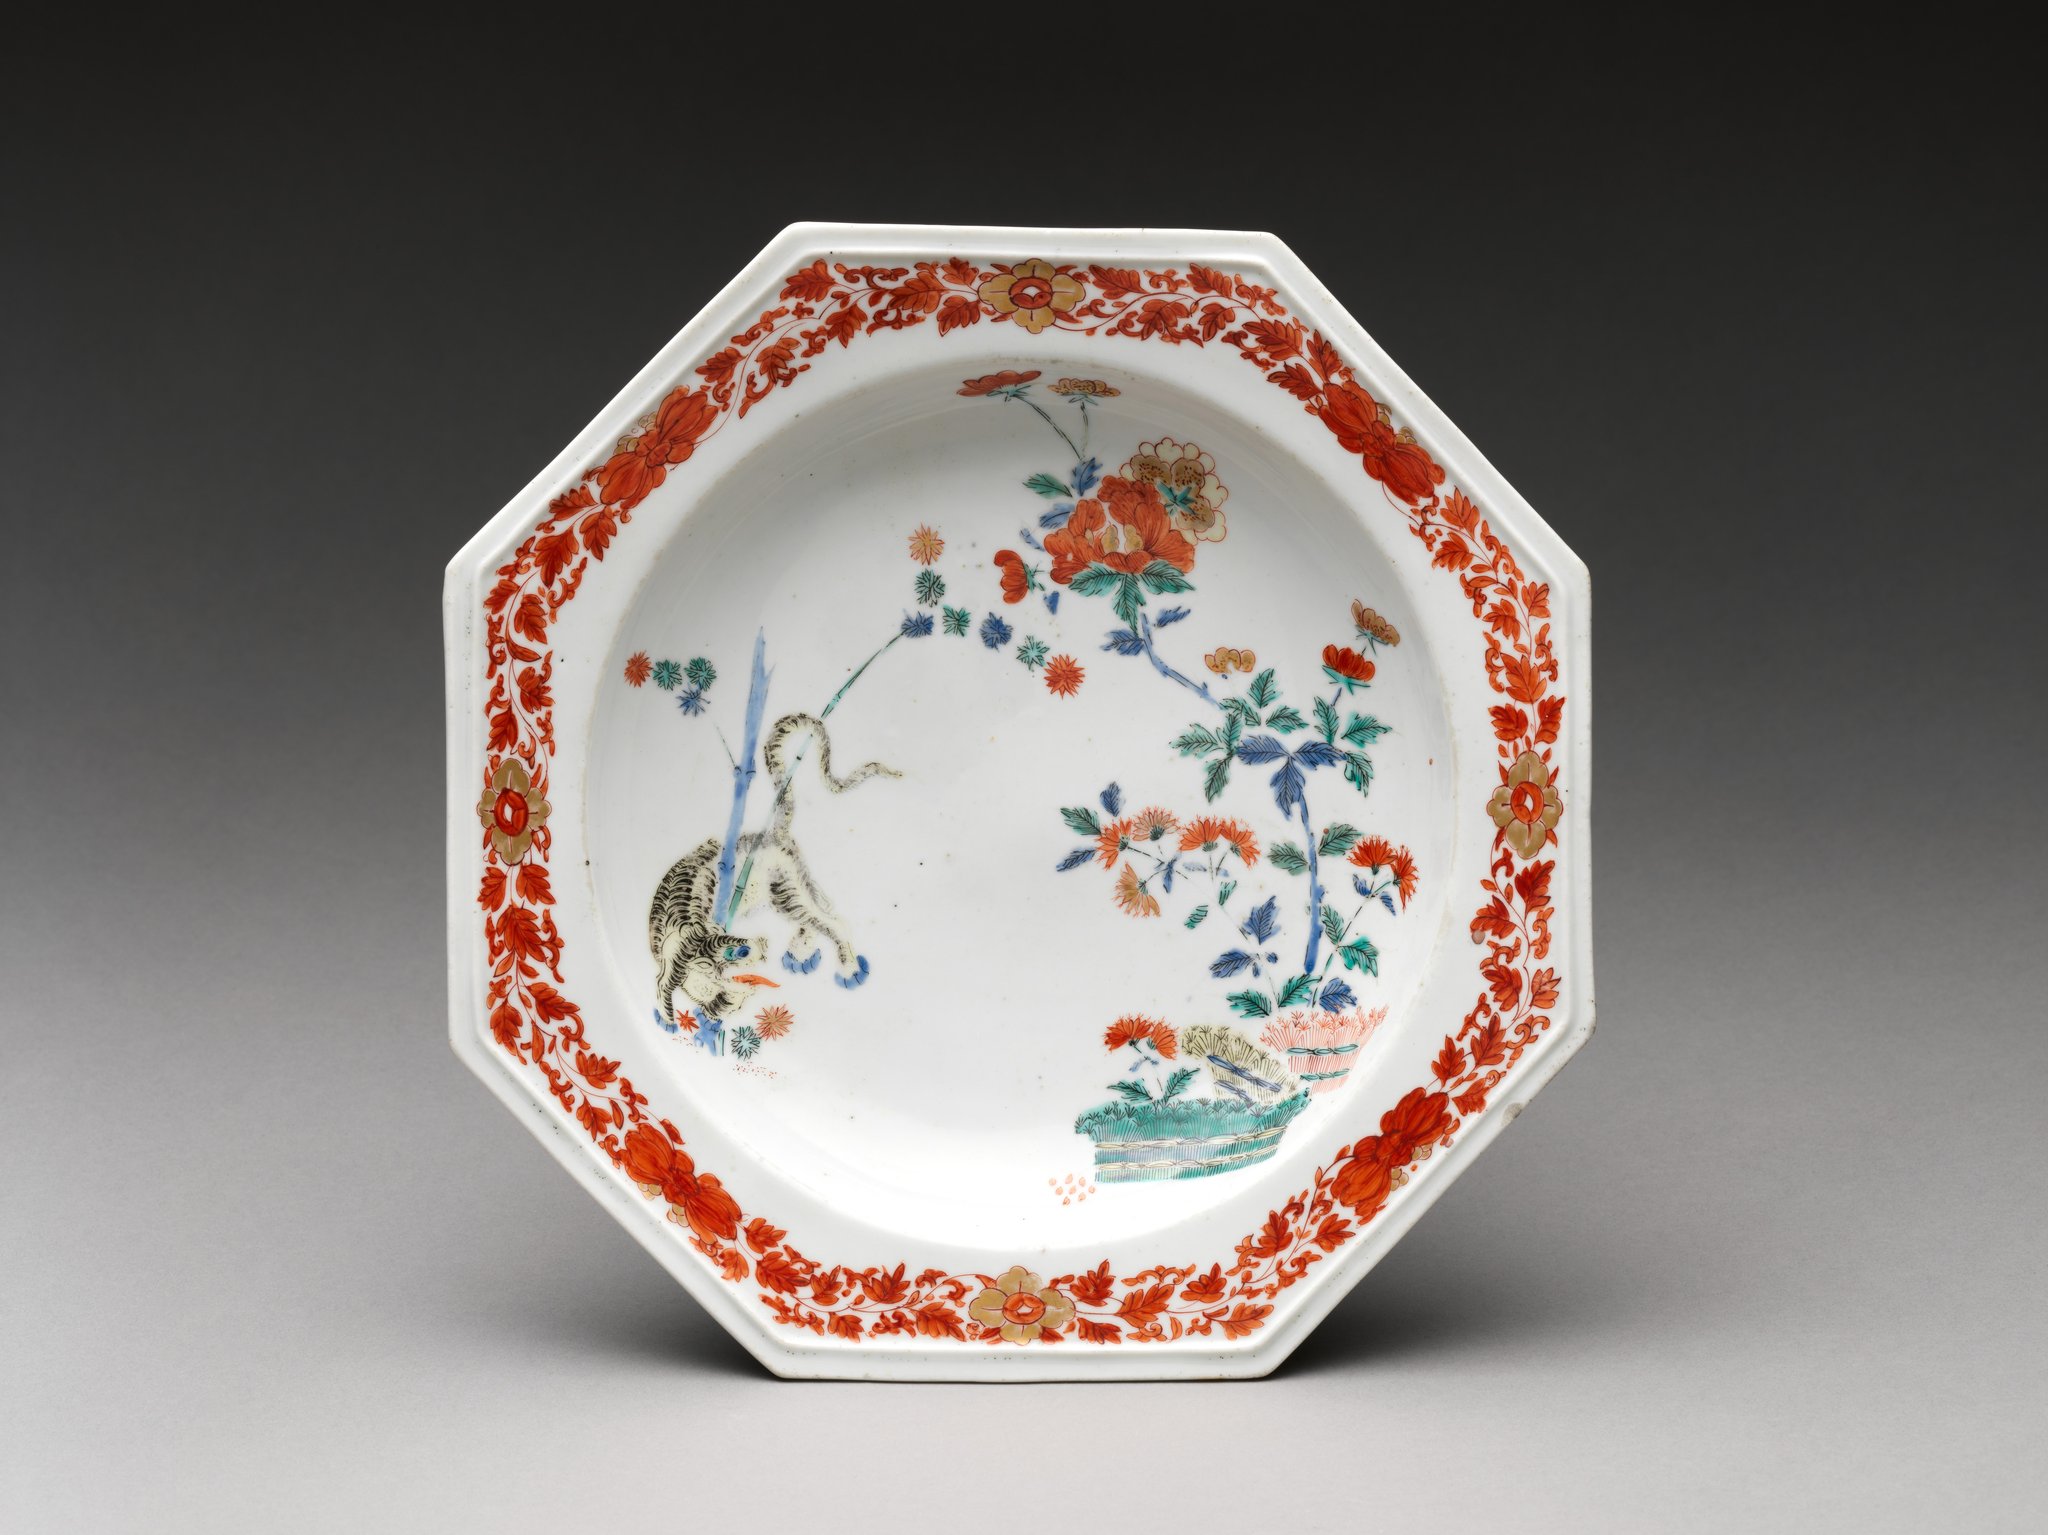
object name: plate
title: Plate with tiger and bamboo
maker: chelsea porcelain manufactory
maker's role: factory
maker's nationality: british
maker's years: 1744-1784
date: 1755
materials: enamel, glaze, soft paste porcelain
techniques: painting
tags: tigers,flowers,bamboo